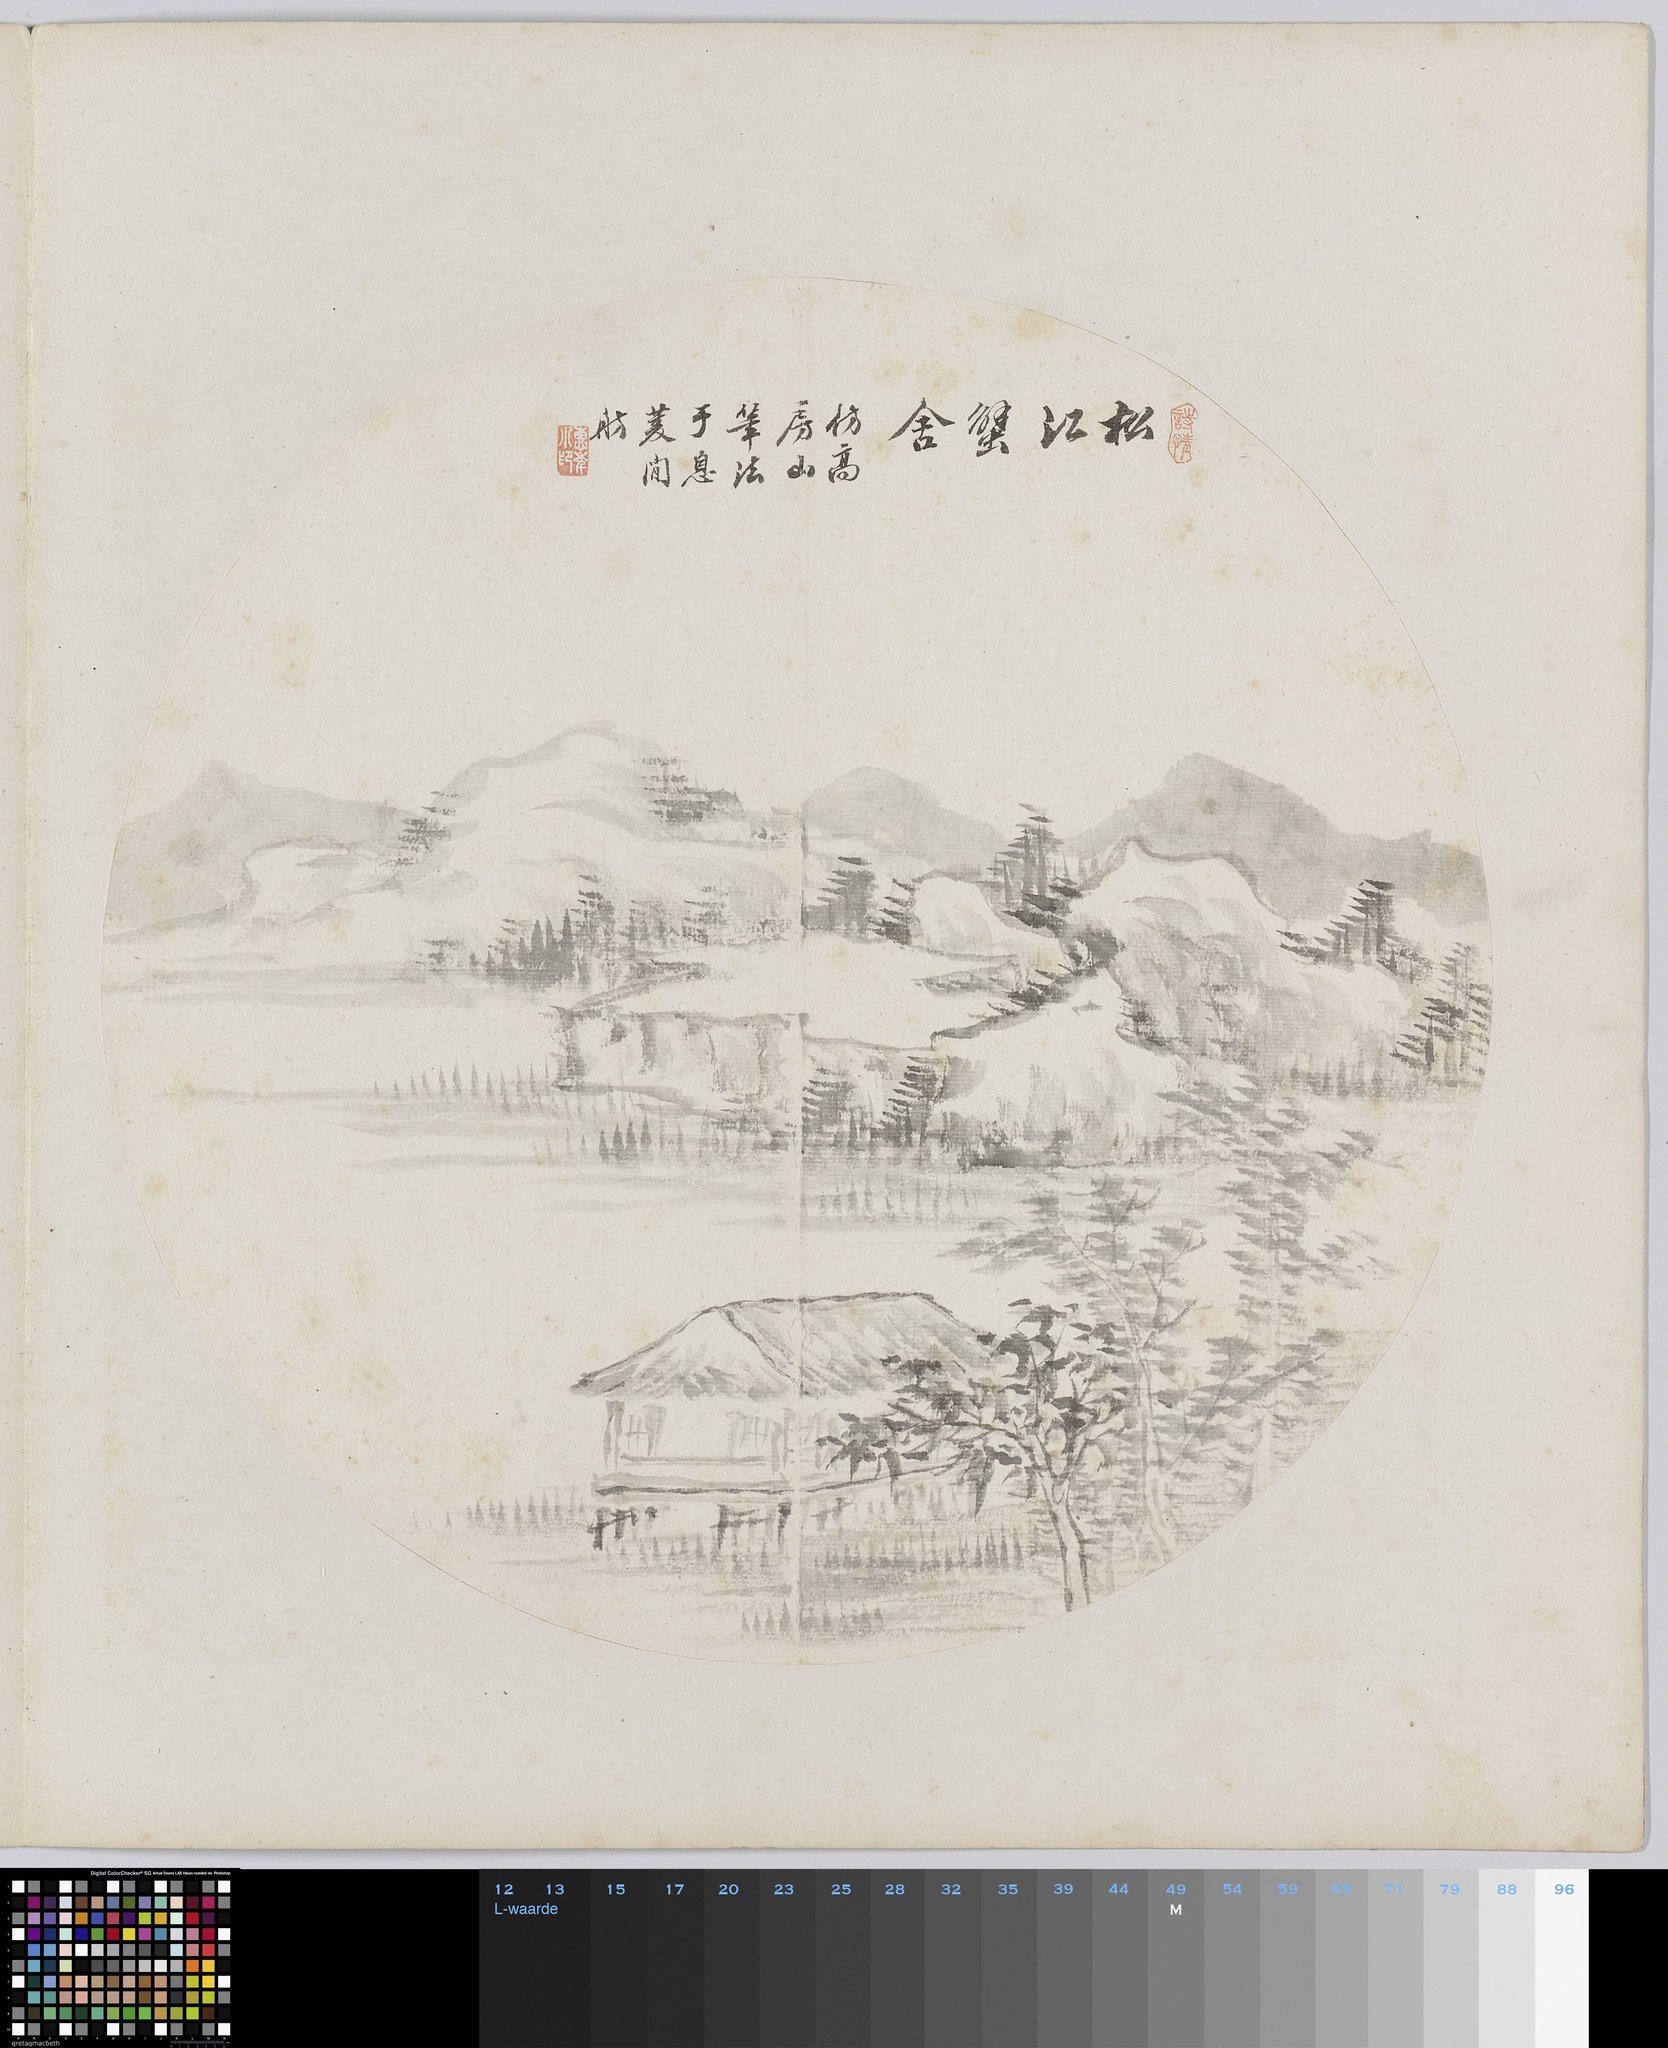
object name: album leaf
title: Albumblad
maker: hui nian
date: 1850-1900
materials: ink, paper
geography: china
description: Albumblad met een landschap. Behoort twee albums met 24 landschappen in de stijl van diverse meesters.